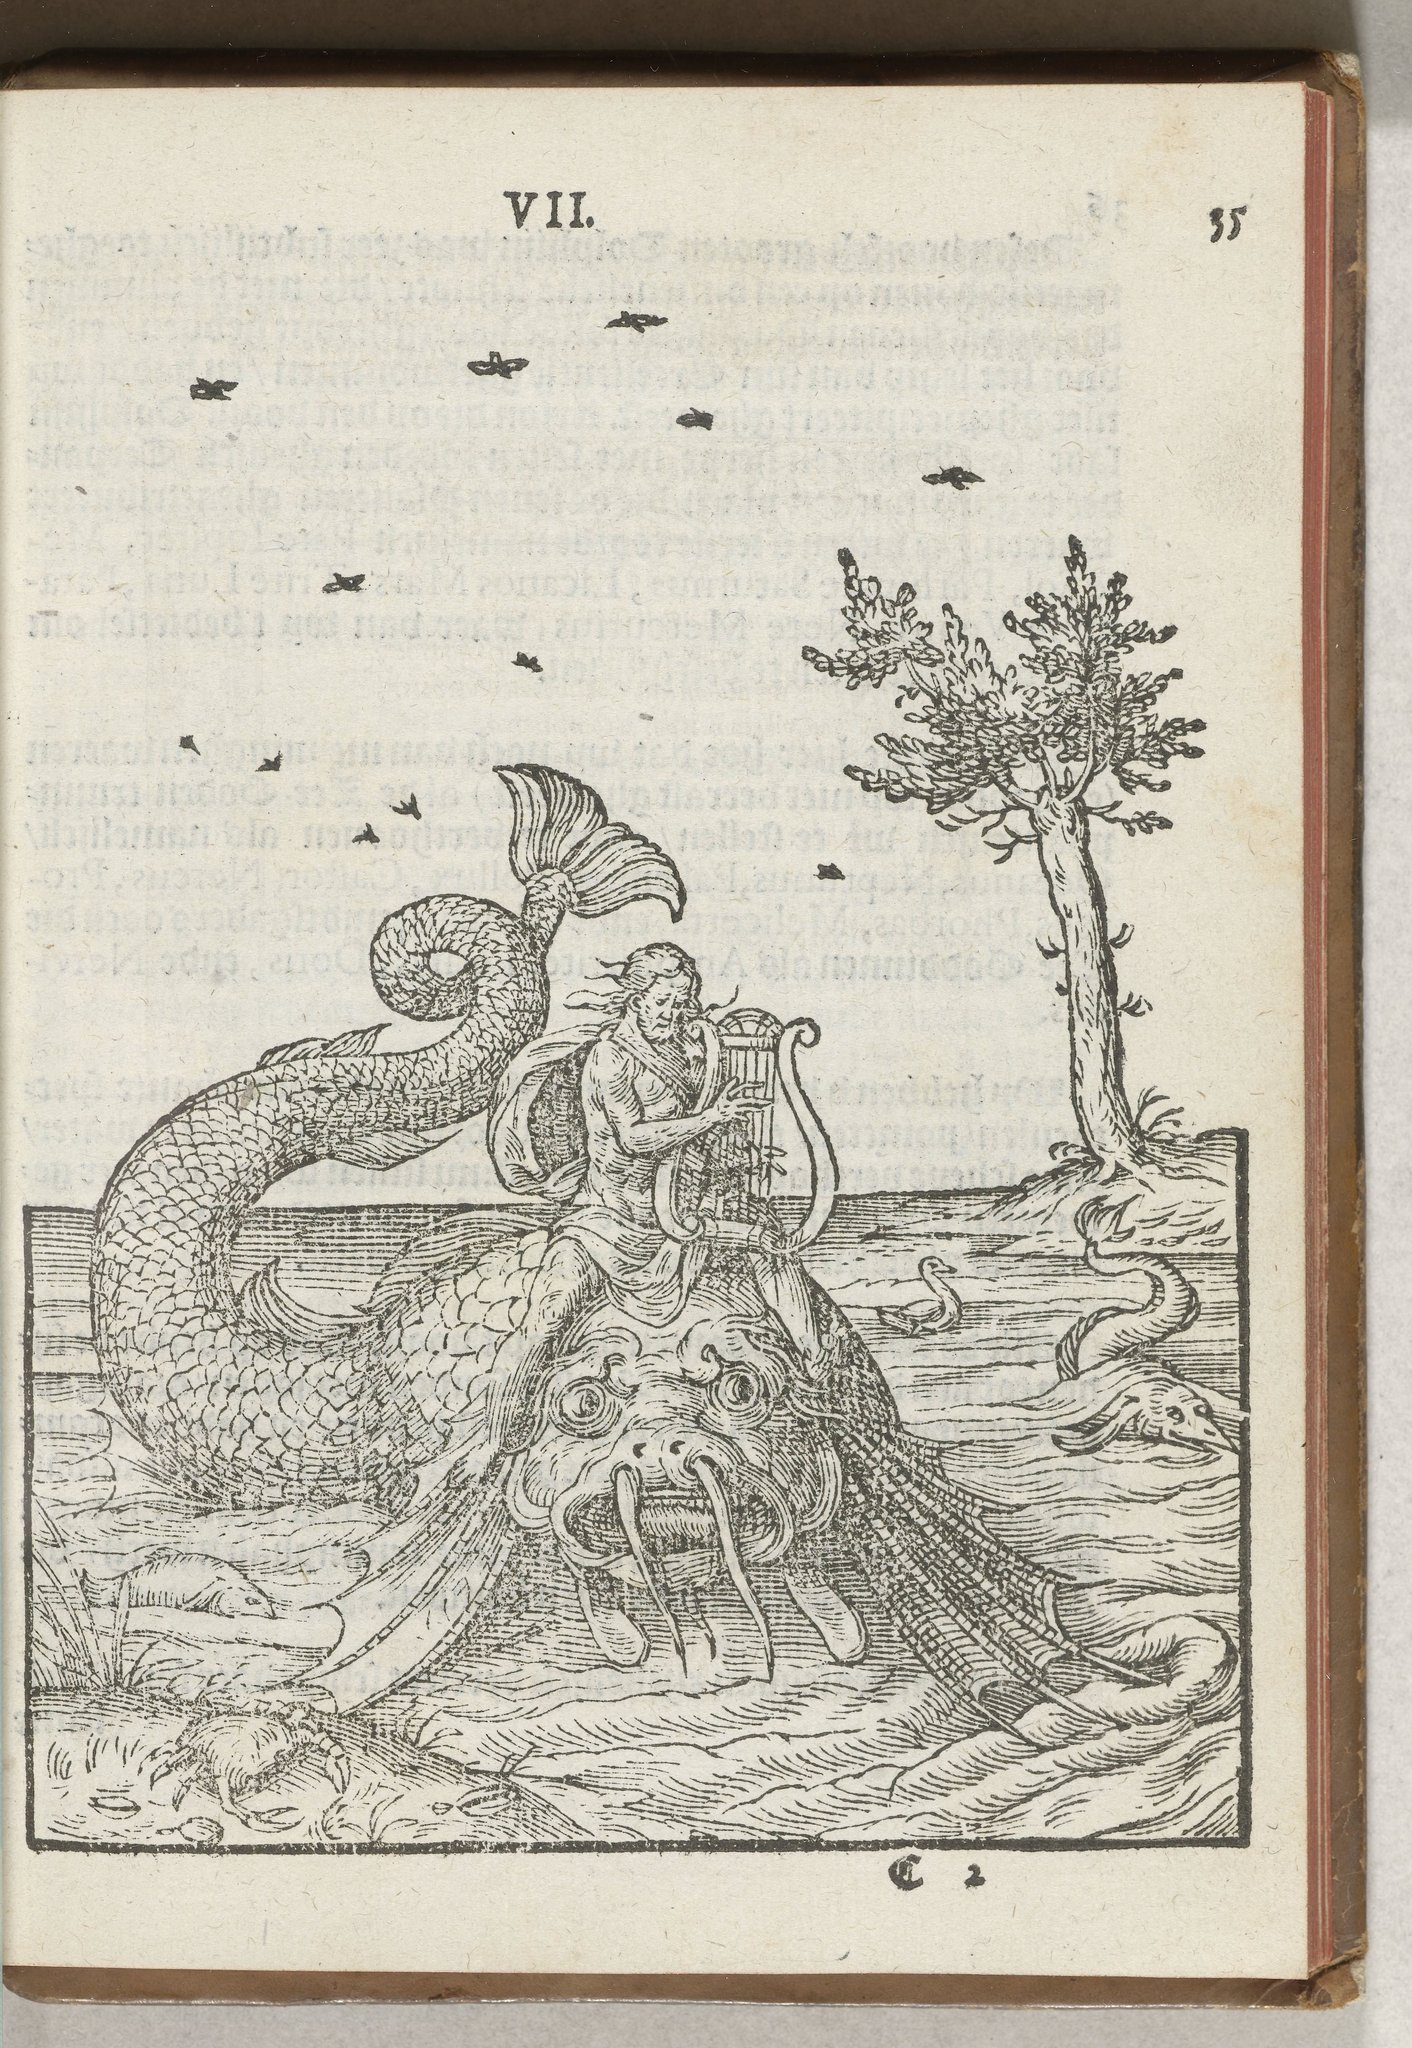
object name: print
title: Voorstelling van Arion op de dolfijn, 1577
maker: antoni van leest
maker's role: print maker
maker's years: 1545-1592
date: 1577-1578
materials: paper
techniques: woodcut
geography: netherlands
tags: delft, william i (prince of orange), triumphal entry and public reception, pageant, 'entrée solennelle', 'joyeuse entrée', arion rides on a dolphin, holding his lyre, brussels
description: Illustratie in: J. B. Houwaert, Declaratie van die triumphante incompst vande doorluchtighen ende hoogheboren Prine van Oraingnien, binnen die princelijcke stadt van Brussele, geschiet in t' iaer ... 1578, den 18 Septembris, Christoffel Plantijn, Antwerpen 1579. Boek in de bibliotheek met signatuur: 325 D 29.